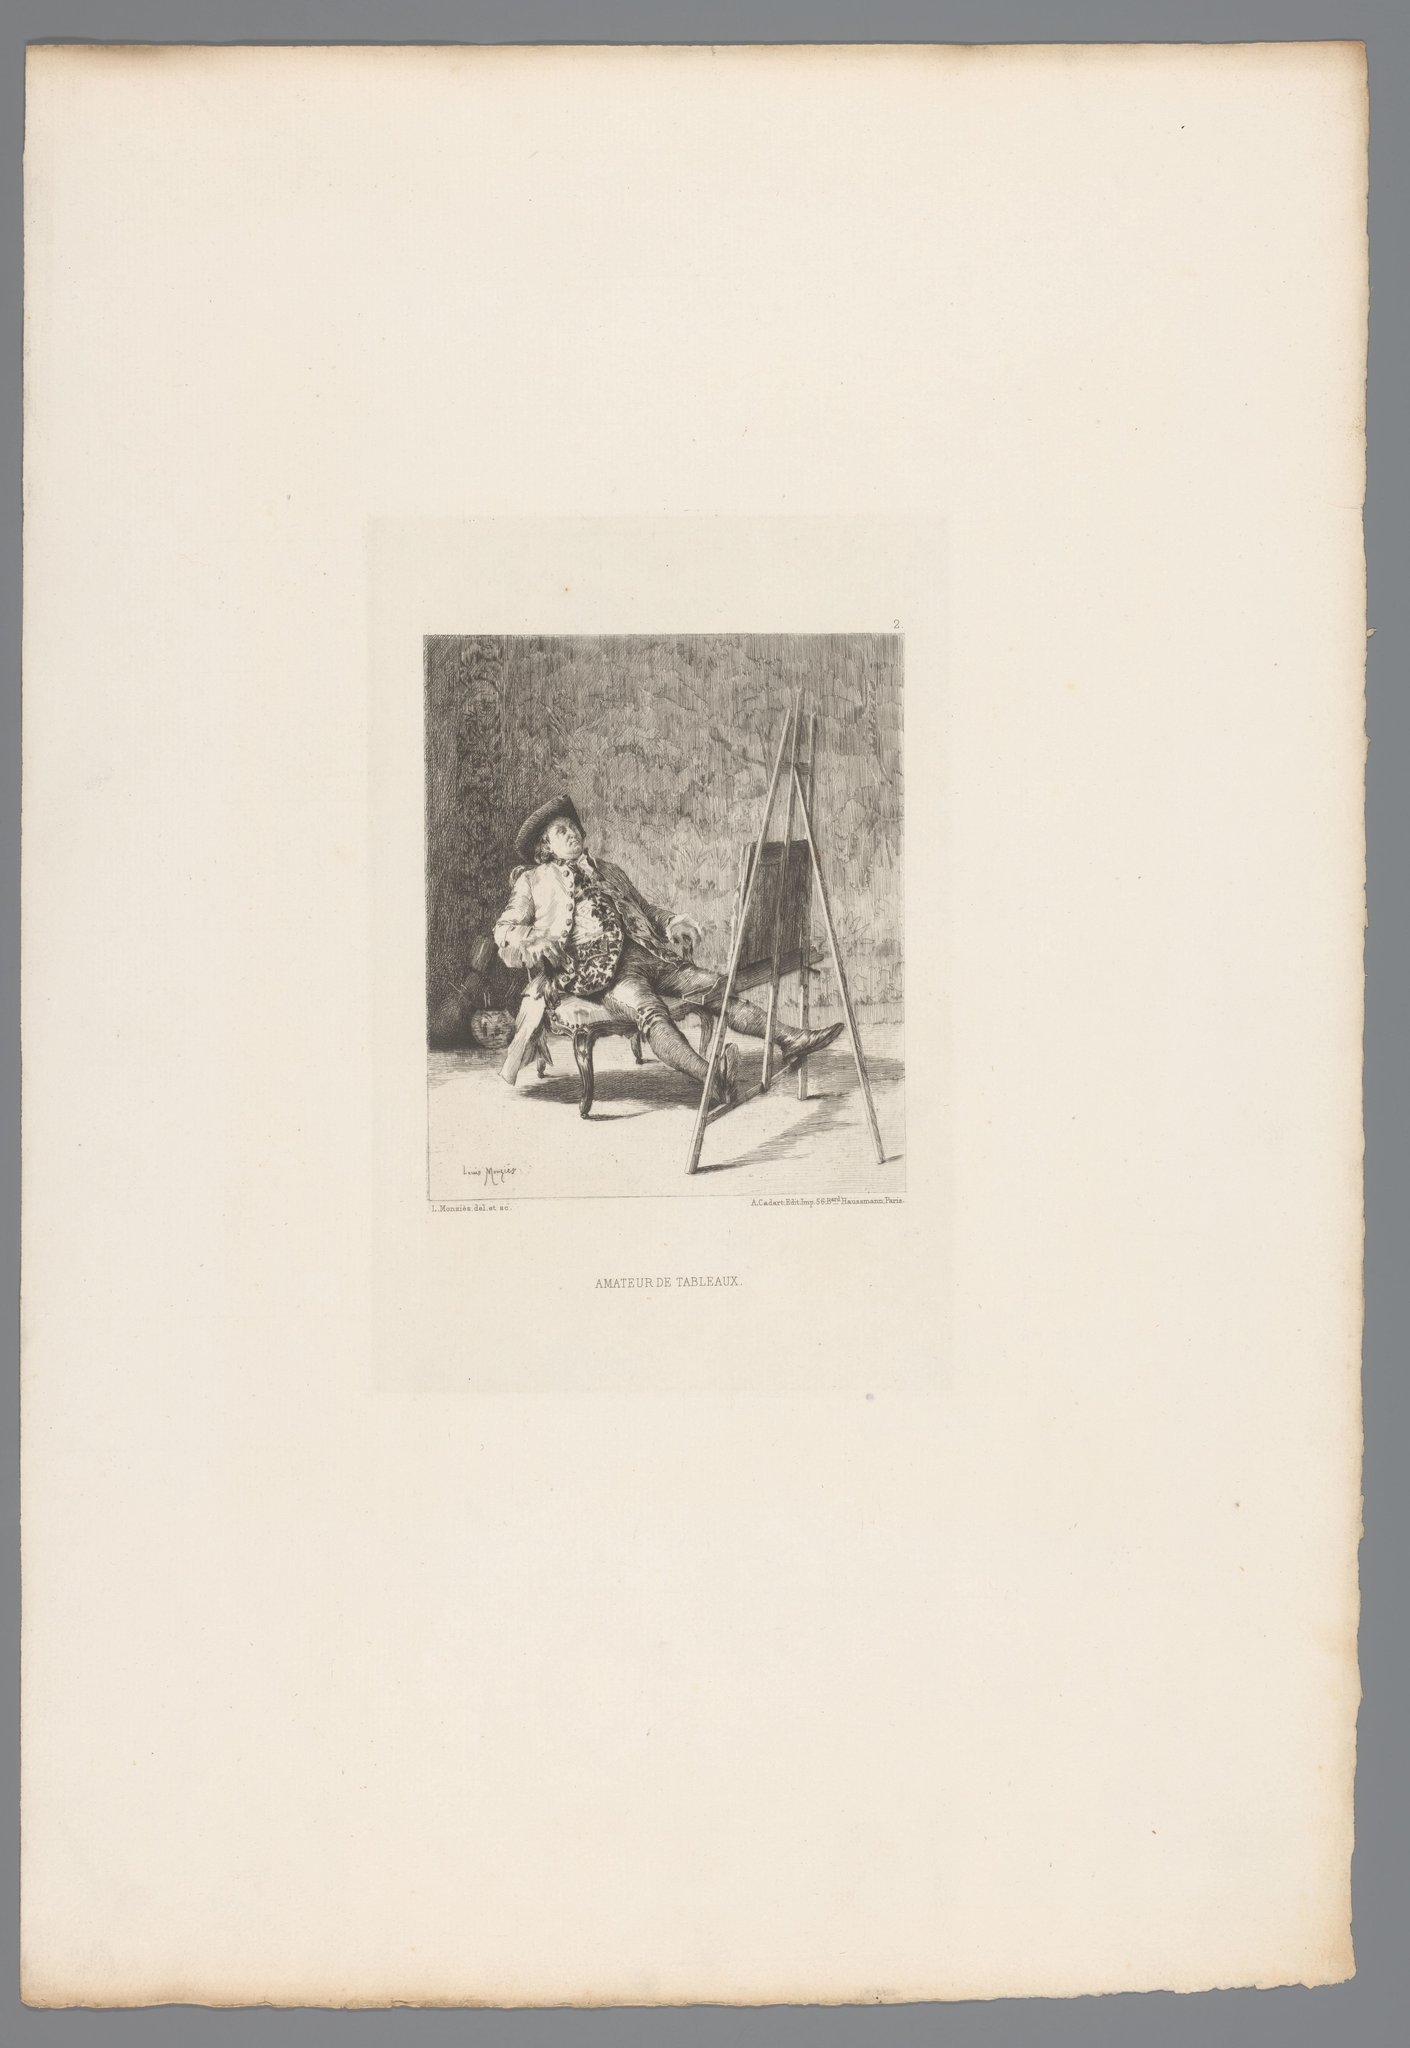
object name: print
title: Man zittend voor schildersezel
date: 1875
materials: paper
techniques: drypoint, etching, intaglio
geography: paris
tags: art collector, person stimulating the arts; art lover, connoisseur, maecenas, patron, picture, painting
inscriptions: collector's mark: Lugt 2760, collector's mark: ‘AFE v S’, collector's mark: Lugt 2228